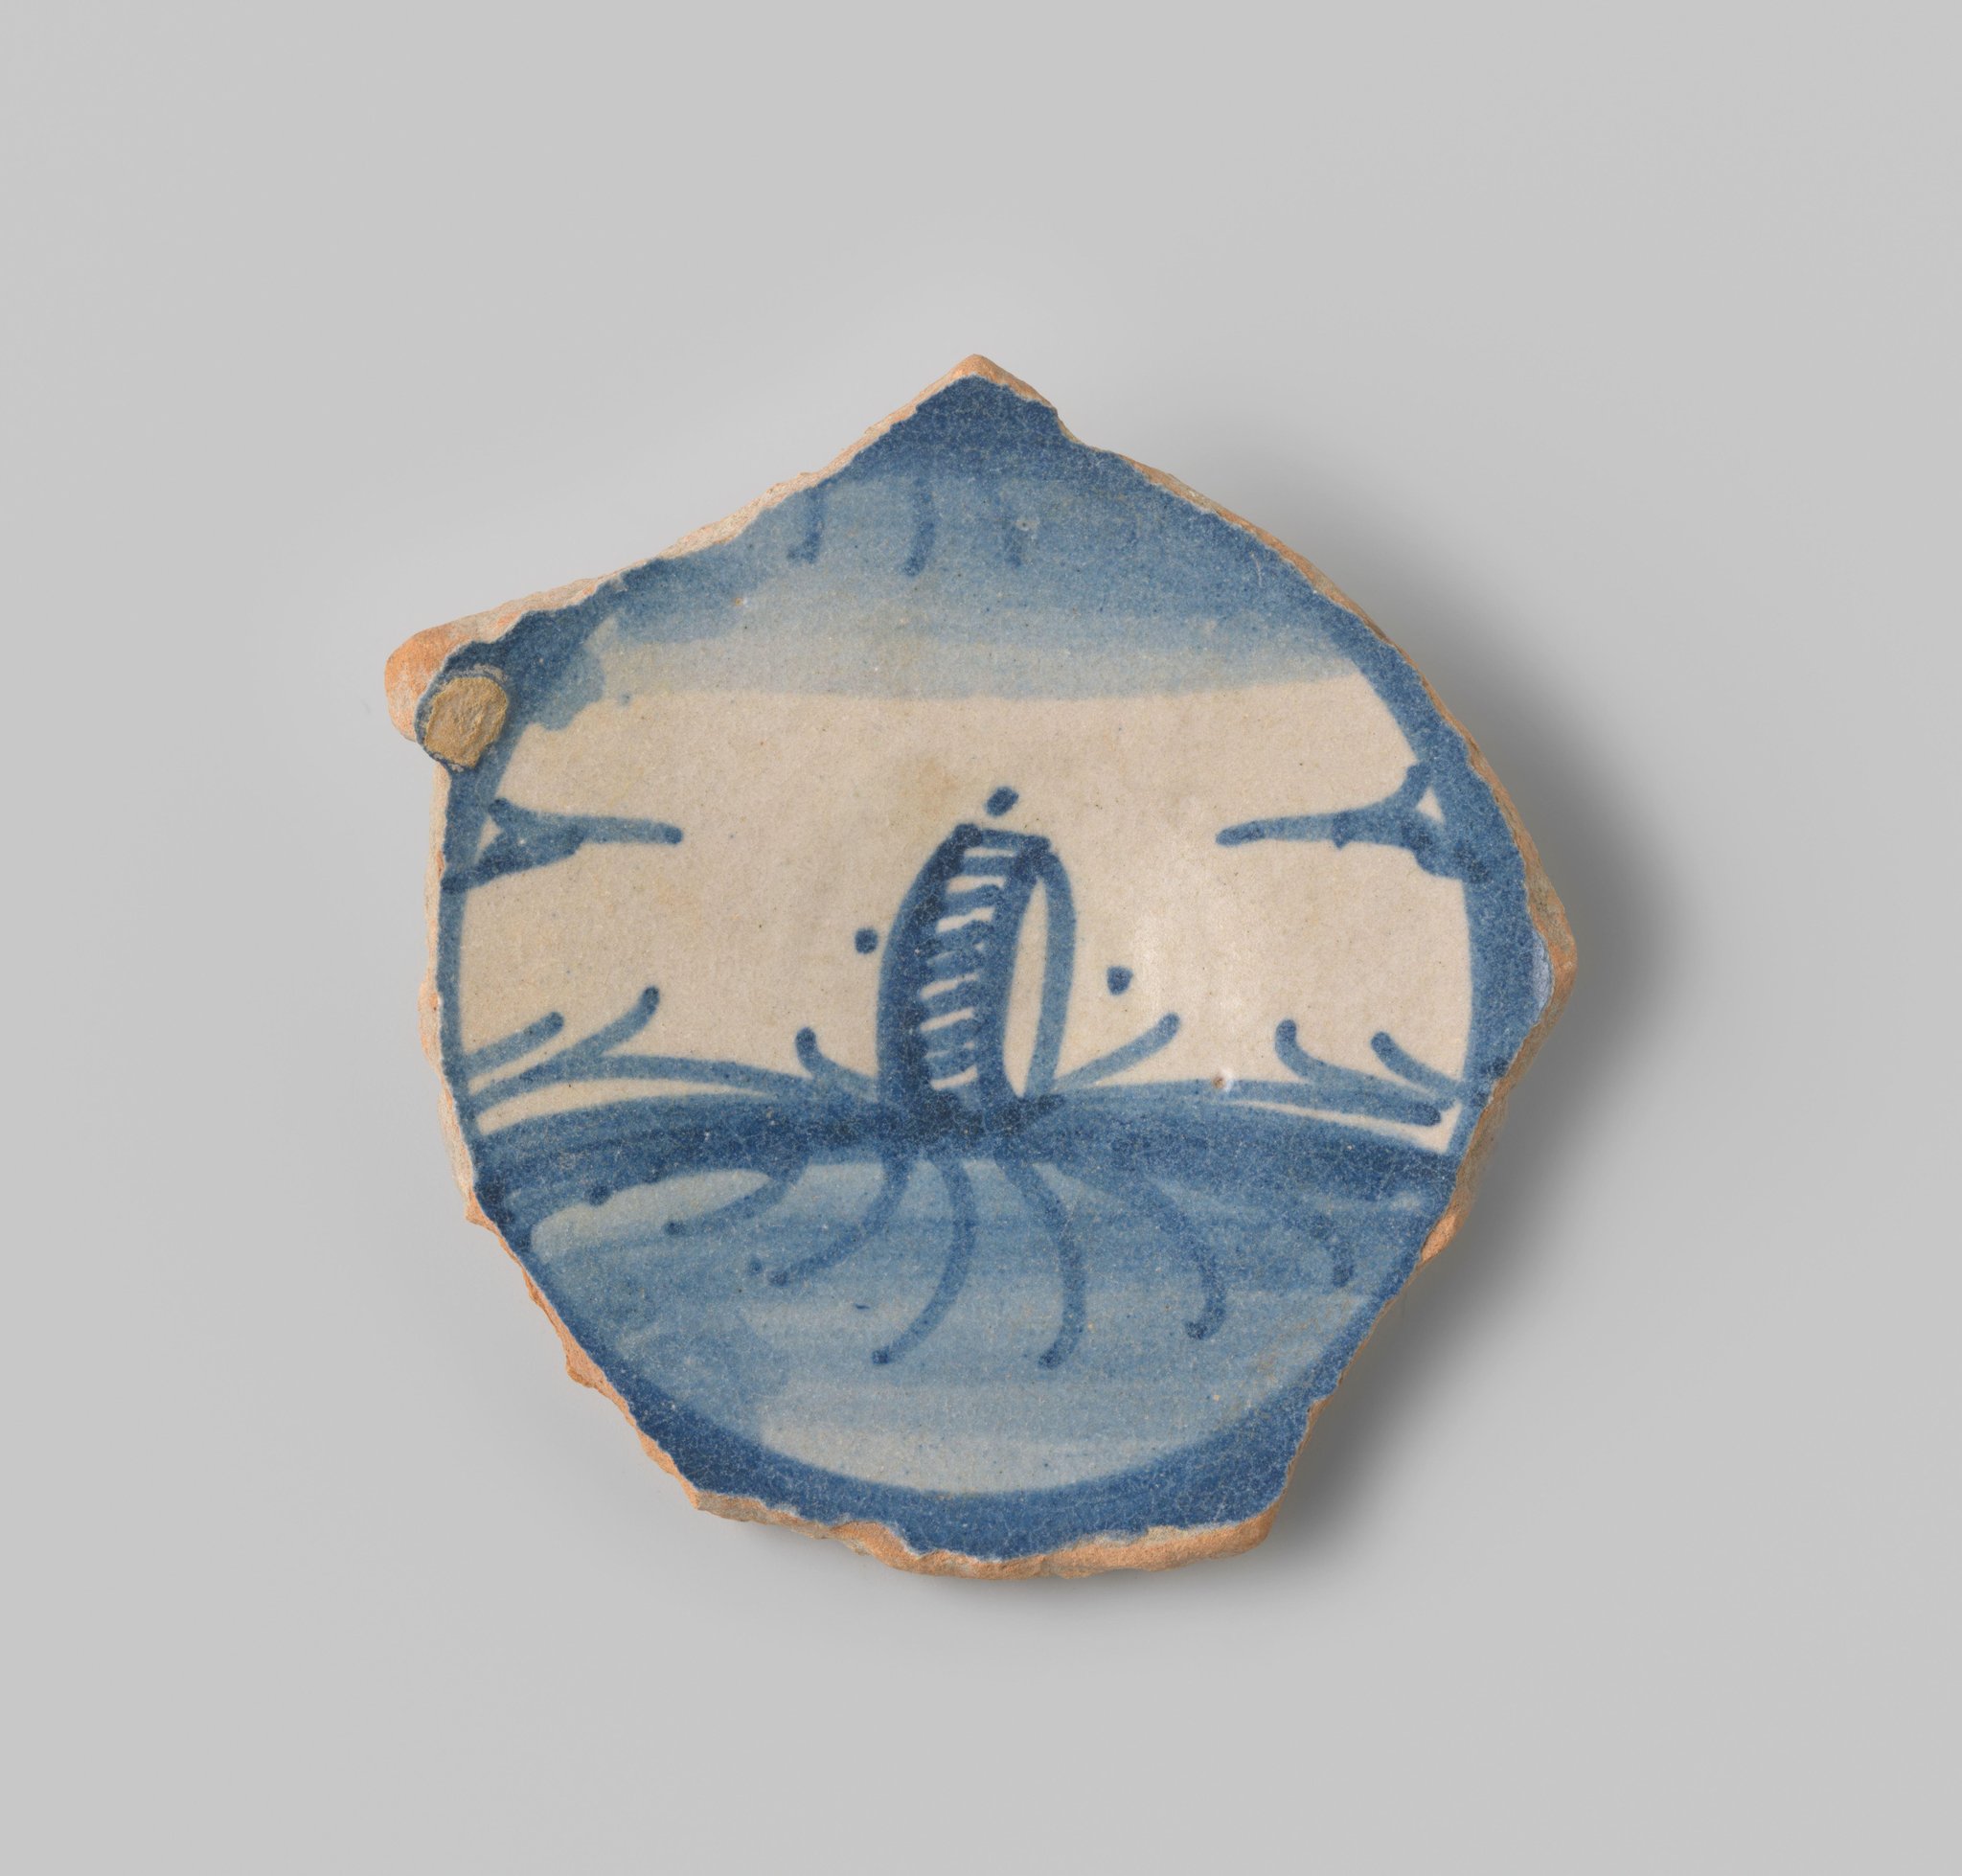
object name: sherd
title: Scherf van aardewerk met rossige scherf, met voetring, aan de voorzijde voorzien van een decoratie in blauw op wit glazuur, aan de achterzijde van wit glazuur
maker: Anonymous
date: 1200-1899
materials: earthenware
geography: italy